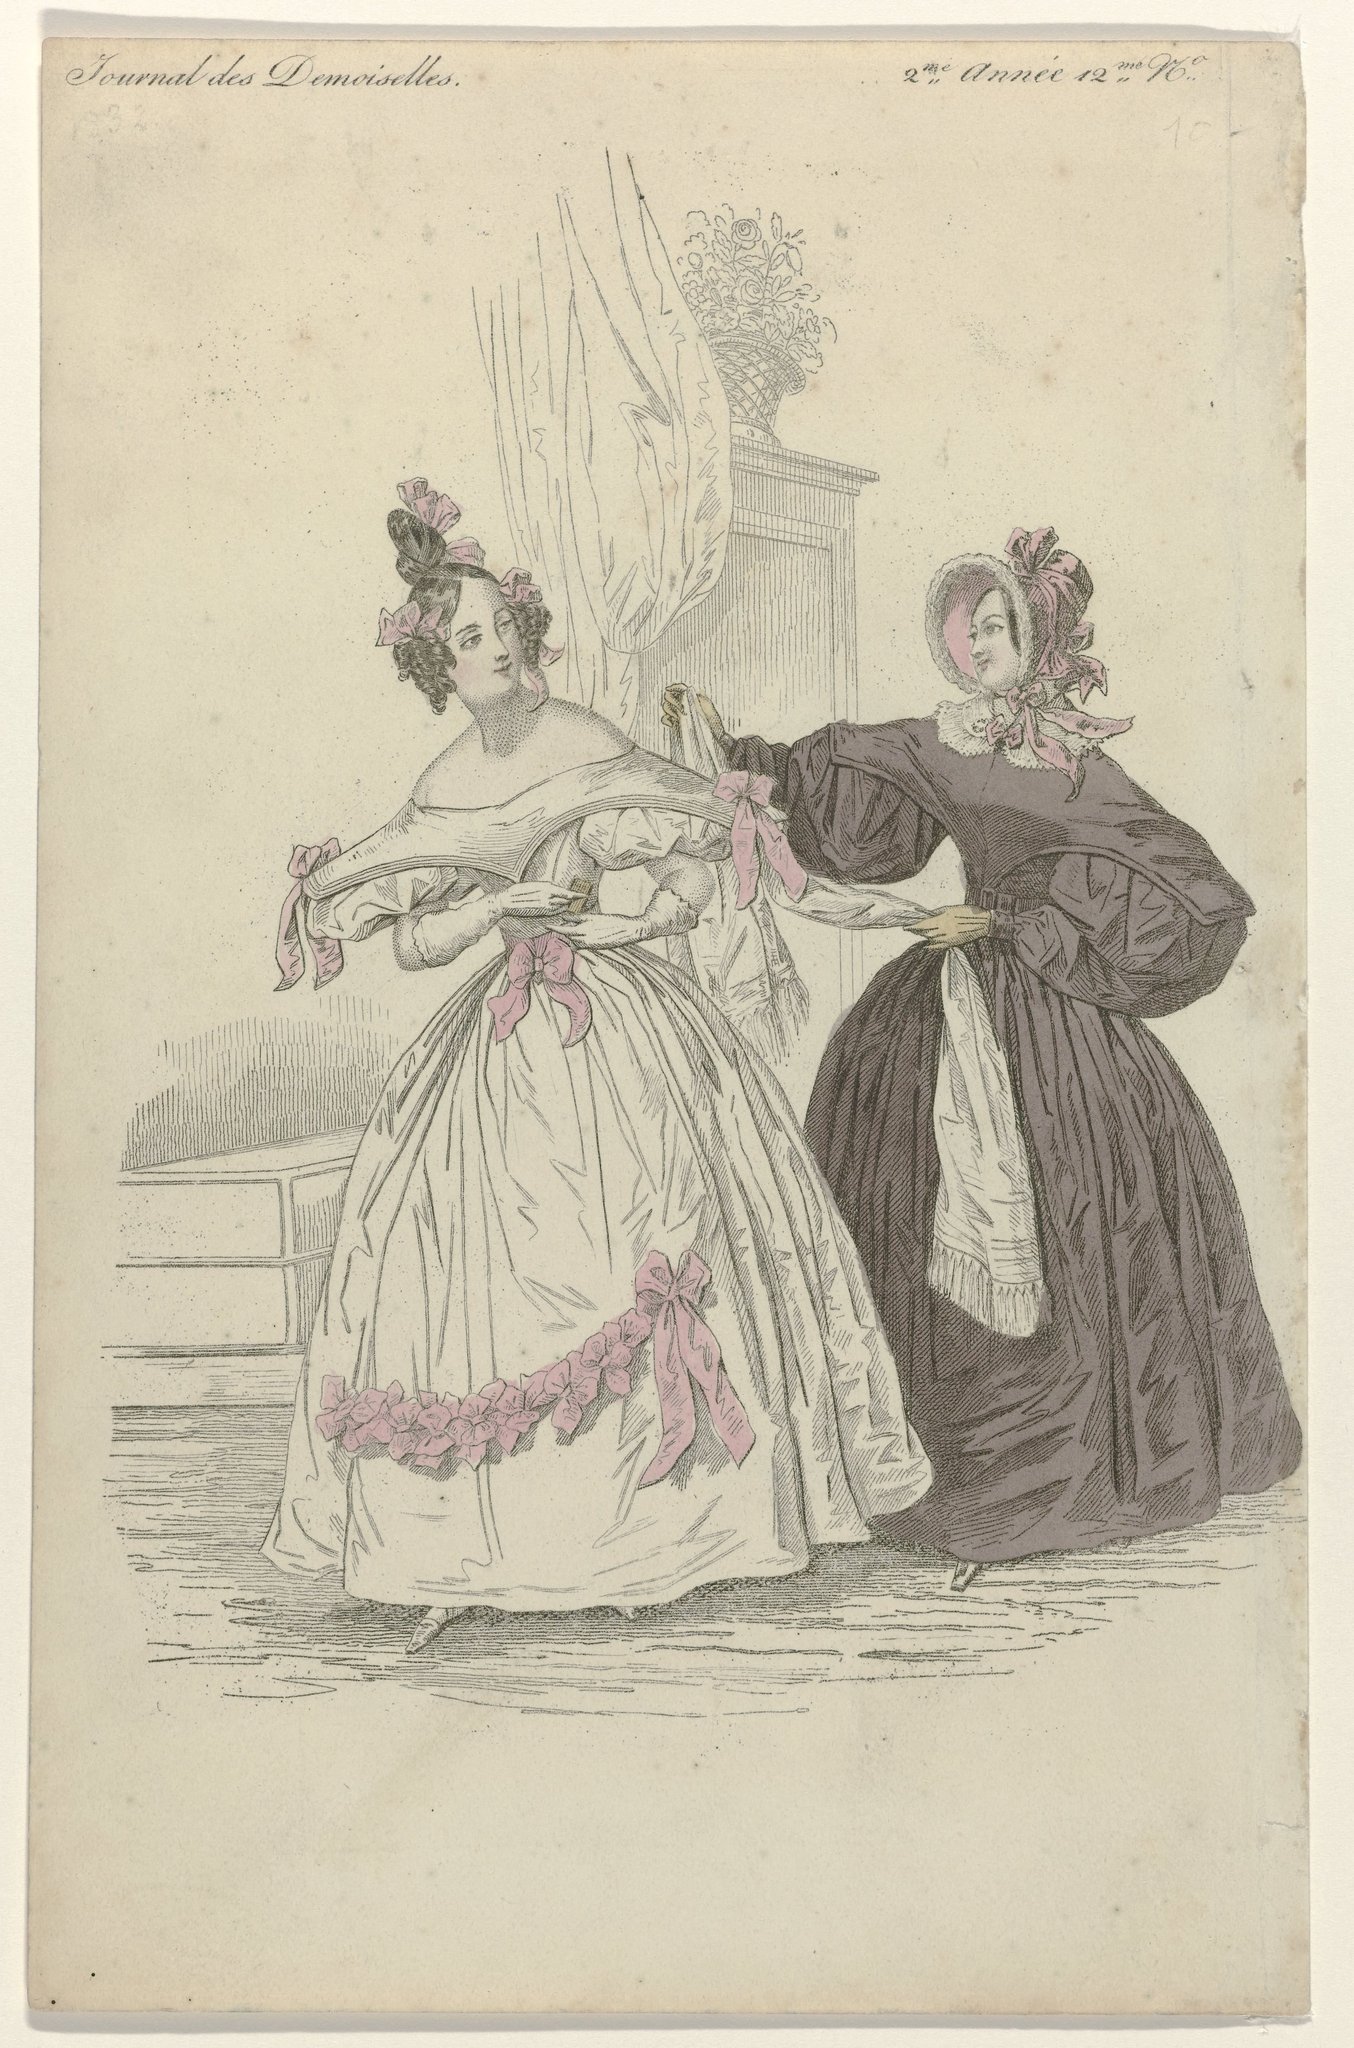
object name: fashion print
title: Journal des Demoiselles, ca. 1833, 2me Année 12e No.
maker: Anonymous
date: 1833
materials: paper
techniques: engraving, hand coloring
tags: bow (ornamental part of clothing) (+ women's clothes), dress, gown: evening dress (+ women's clothes), gloves, mittens (long gloves) (+ women's clothes), clothing for the upper part of the body (shawl) (+ women's clothes), head-gear (+ women's clothes), fashion plates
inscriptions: title: ‘Journal des Demoiselles’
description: Vrouw in avondjapon met boothals en korte pofmouwen. Wijde rok, versierd met guirlande van strikken. Lange handschoenen. Een vrouw reikt haar een sjaal aan, met aan de uiteinden franjes. Zij draagt een hooggesloten japon met schapenboutmouwen. Luifelhoed. Prent uit het modetijdschrift Journal des Demoiselles (1833 -1922).